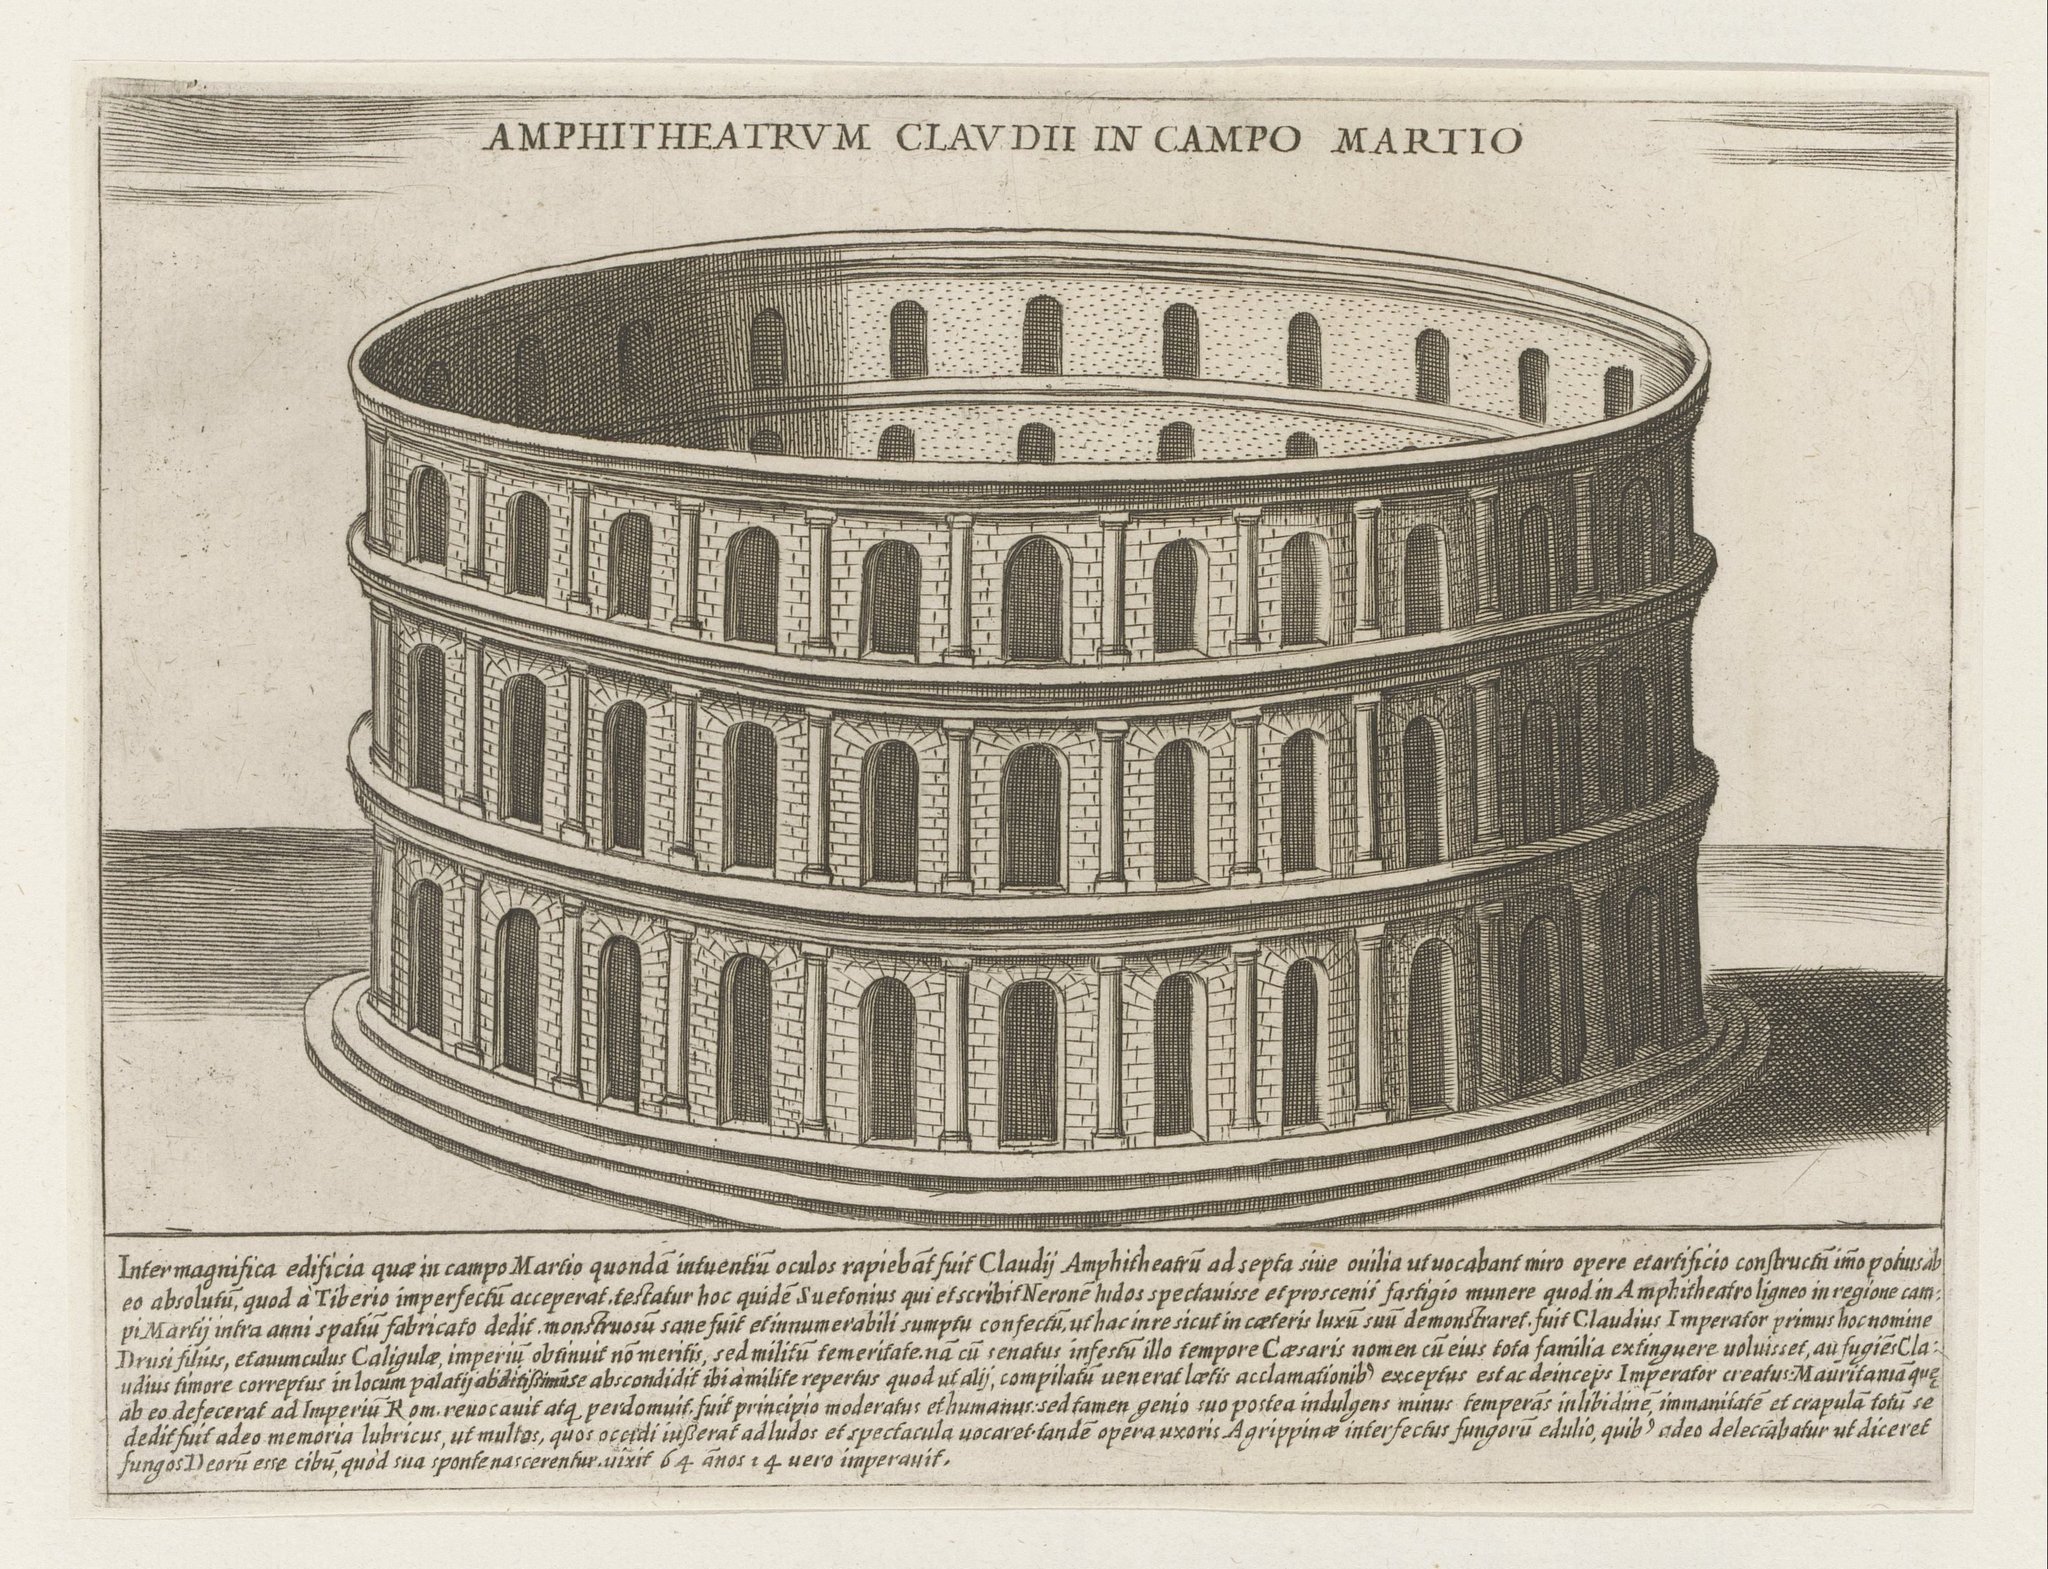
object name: print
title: Antiquae Urbis Splendor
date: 1612-1628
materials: paper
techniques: etching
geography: rome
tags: theatre (building) - aa - open-air performances, representation of real building (either existing or having existed), rome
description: Deze prent maakt deel uit van een set van 158 prenten (+ titelprenten), die verscheen in vier delen. In 1612 verschenen delen één en twee. In 1615 verscheen het derde deel en in 1628 verscheen deel vier. In 1637 publiceerde Vitale Mascardi de eerste heruitgave van de gehele set met nummering.